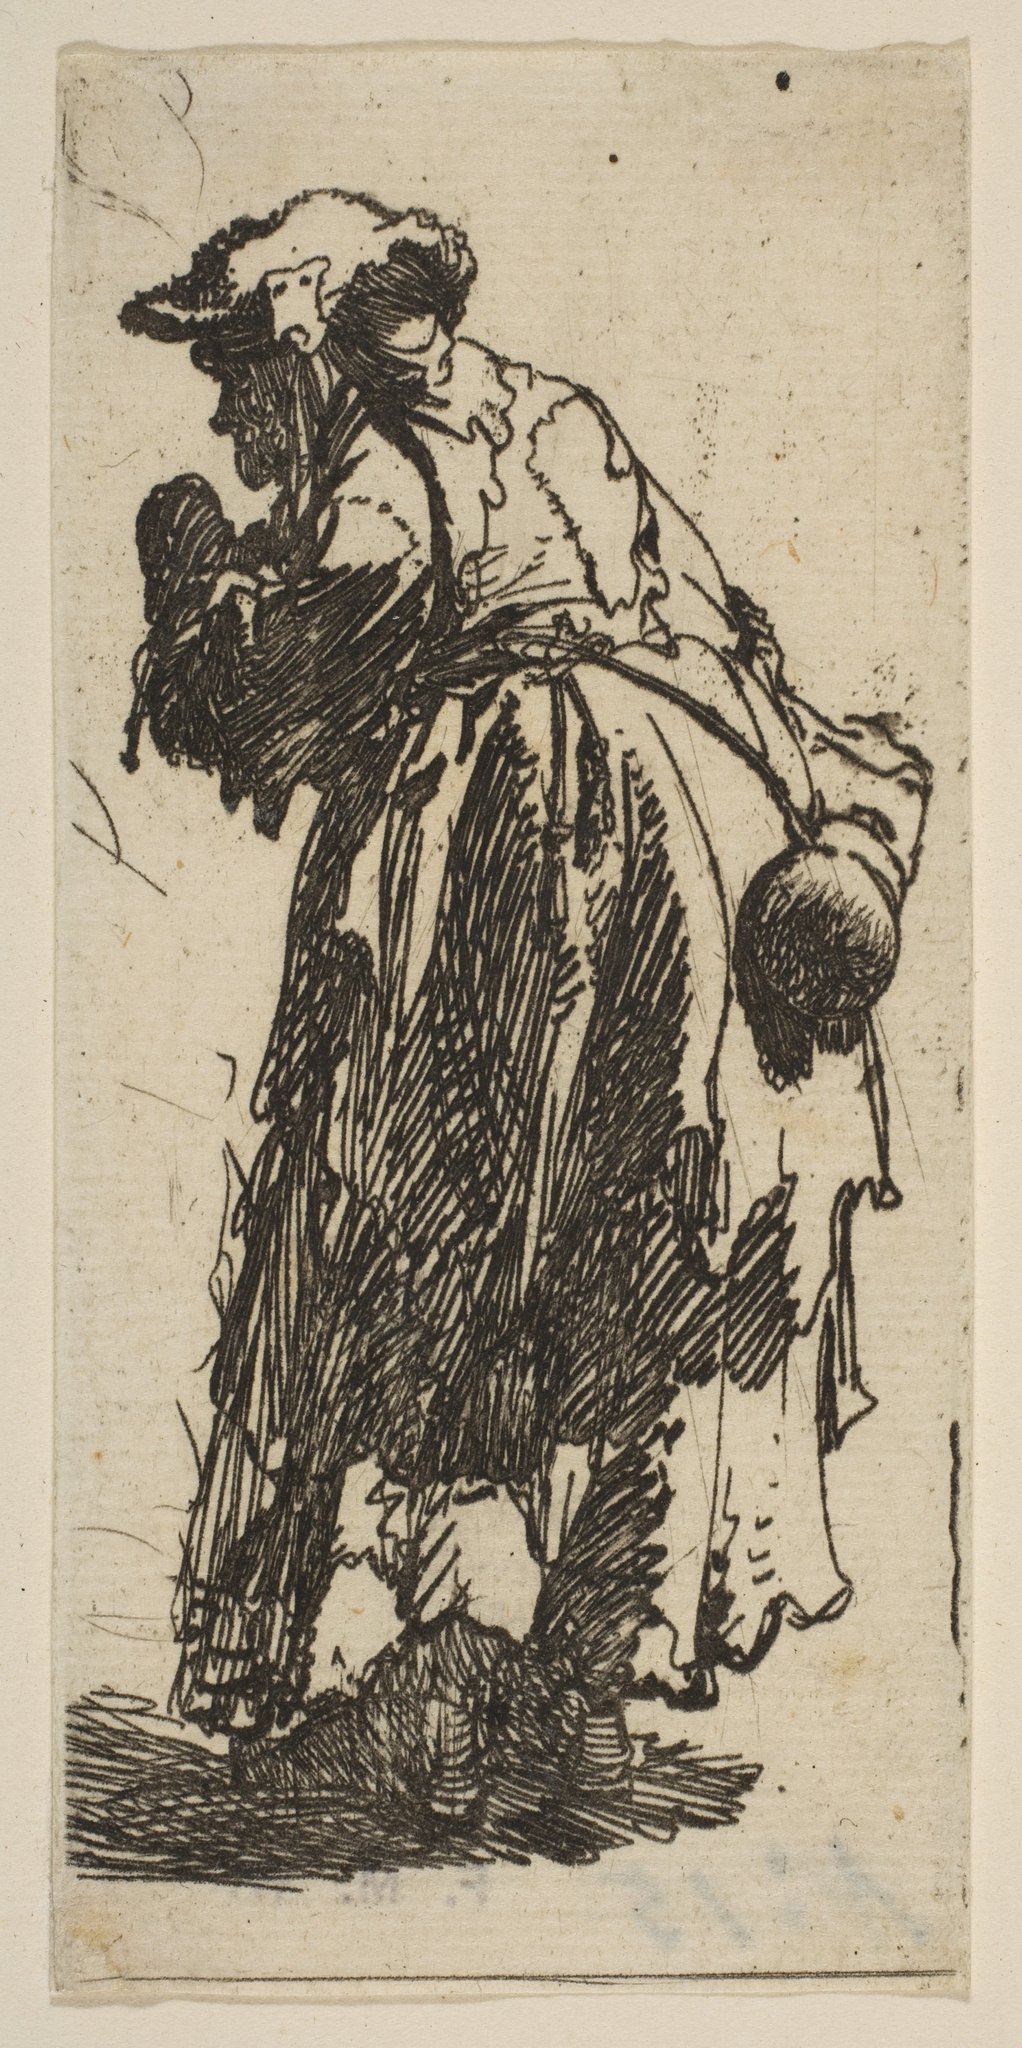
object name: print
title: Old Beggar Woman with a Gourd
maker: rembrandt van rijn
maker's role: artist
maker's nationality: dutch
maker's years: 1606-1669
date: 1629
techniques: etching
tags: women